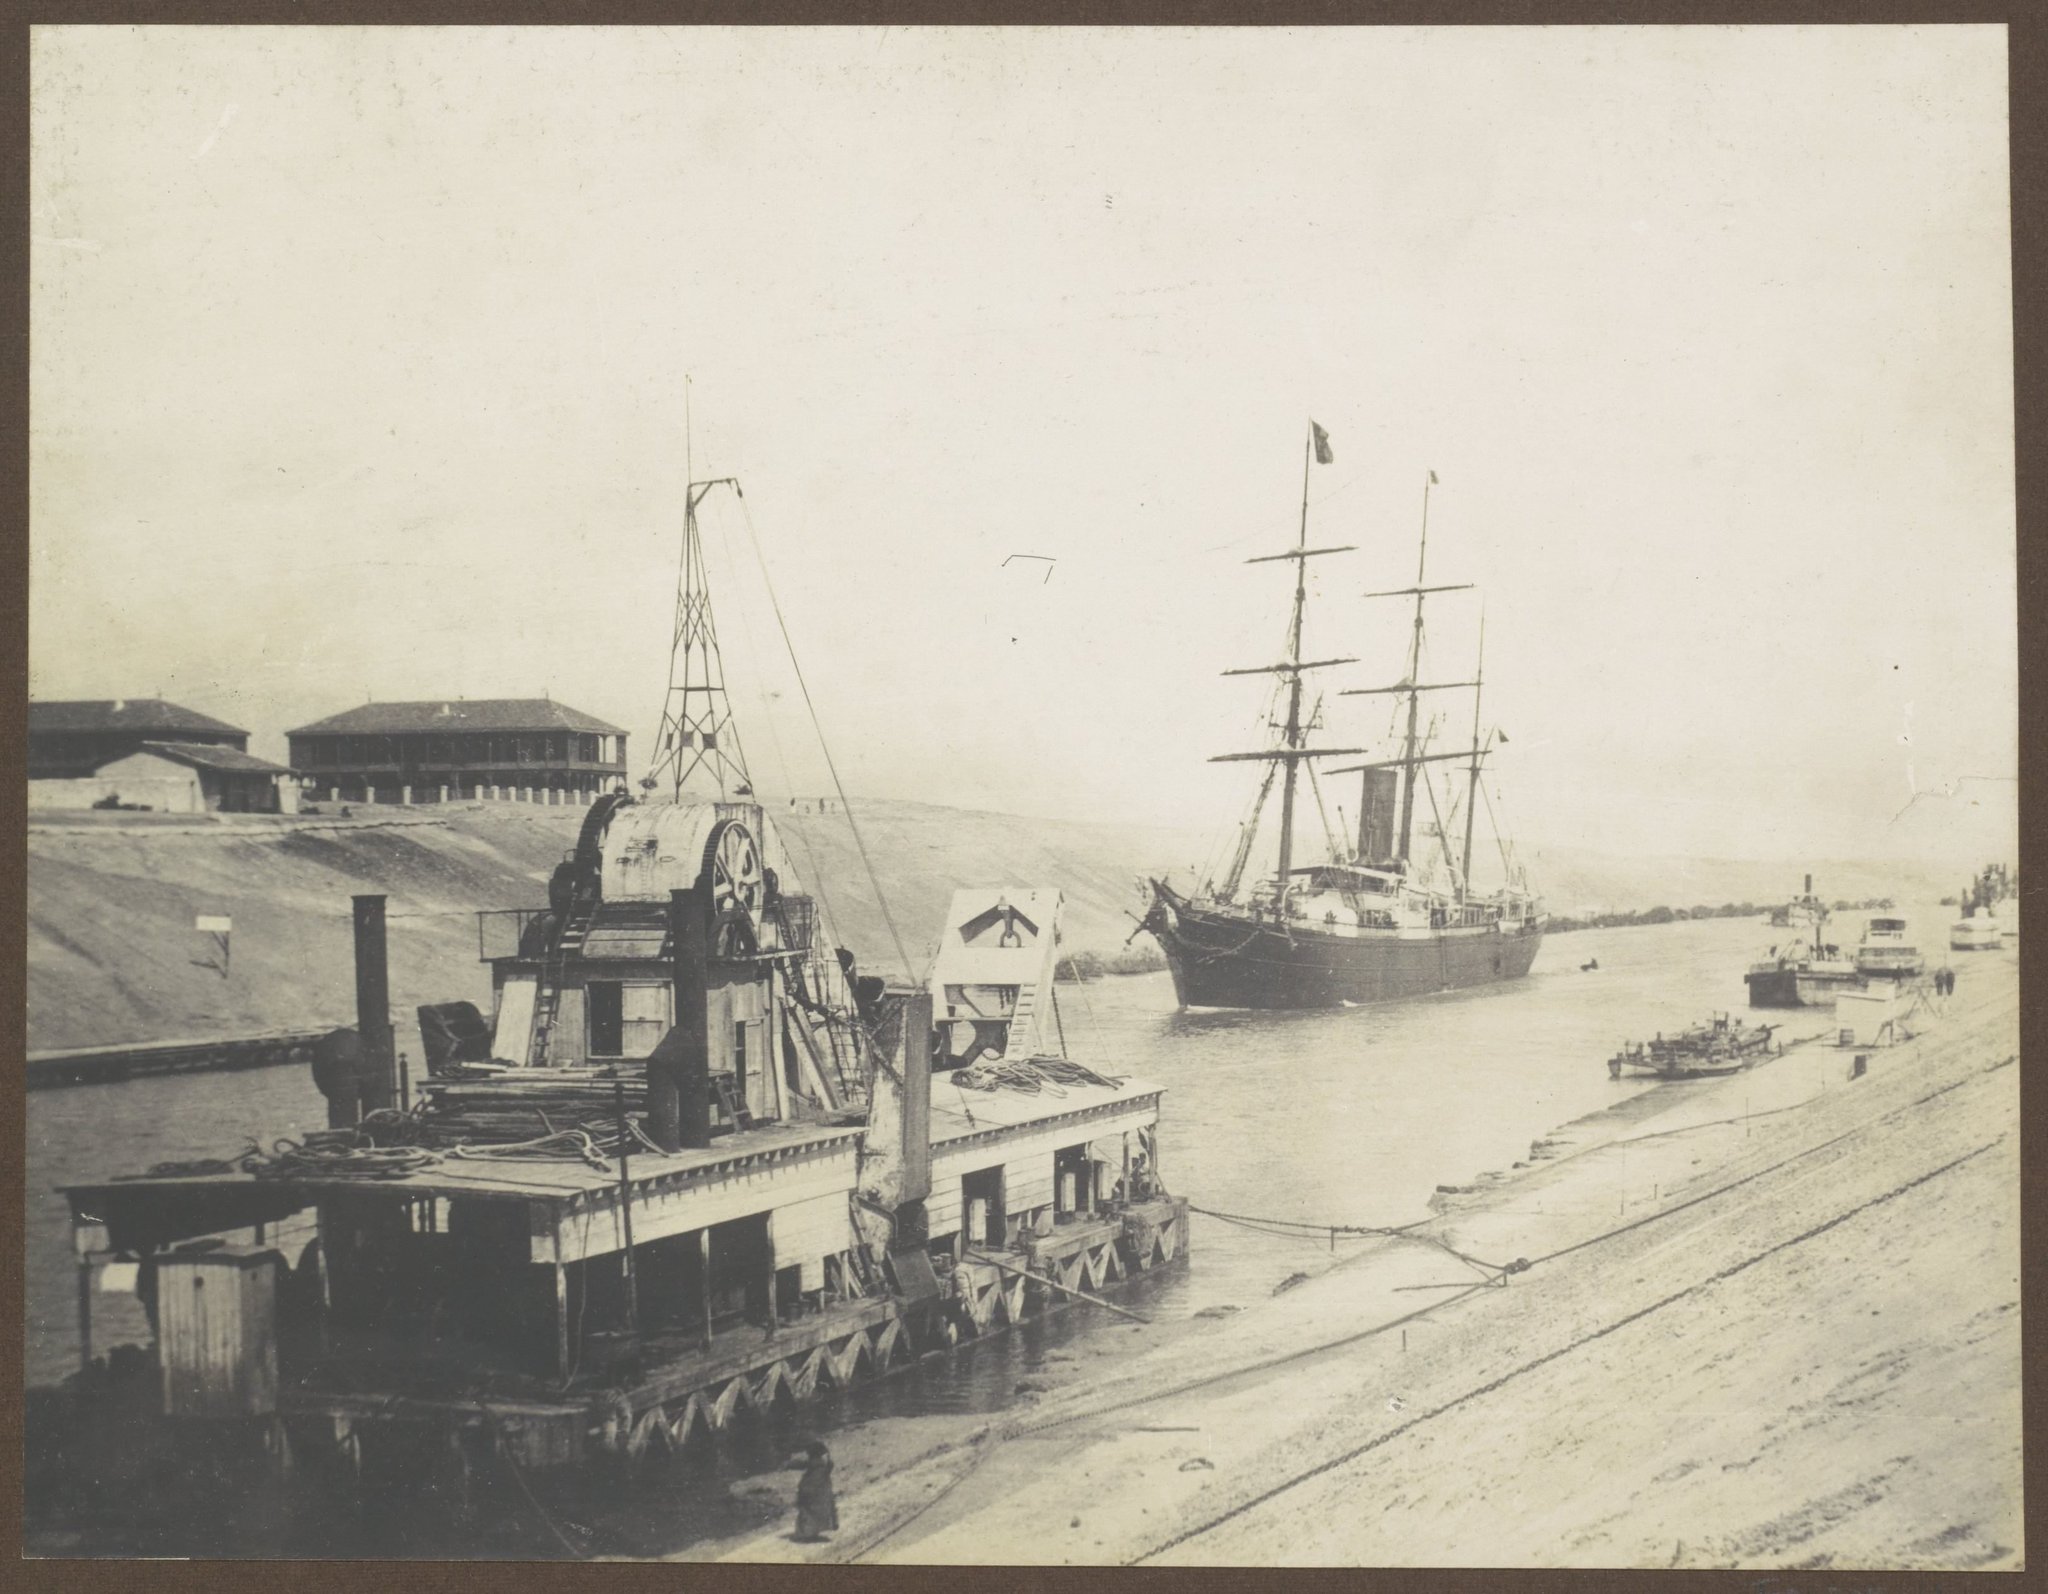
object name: photograph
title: Schip vaart door het Suezkanaal bij een baggerschip en huizen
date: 1880-1900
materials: paper, photographic support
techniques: gelatin silver print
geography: suez canal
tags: sailing-ship, sailing-boat, canal, dredge, dredging machine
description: Onderdeel van Reisalbum met foto's van Duitsland, Zwitserland, het Suezkanaal en Nederlands-Indië.